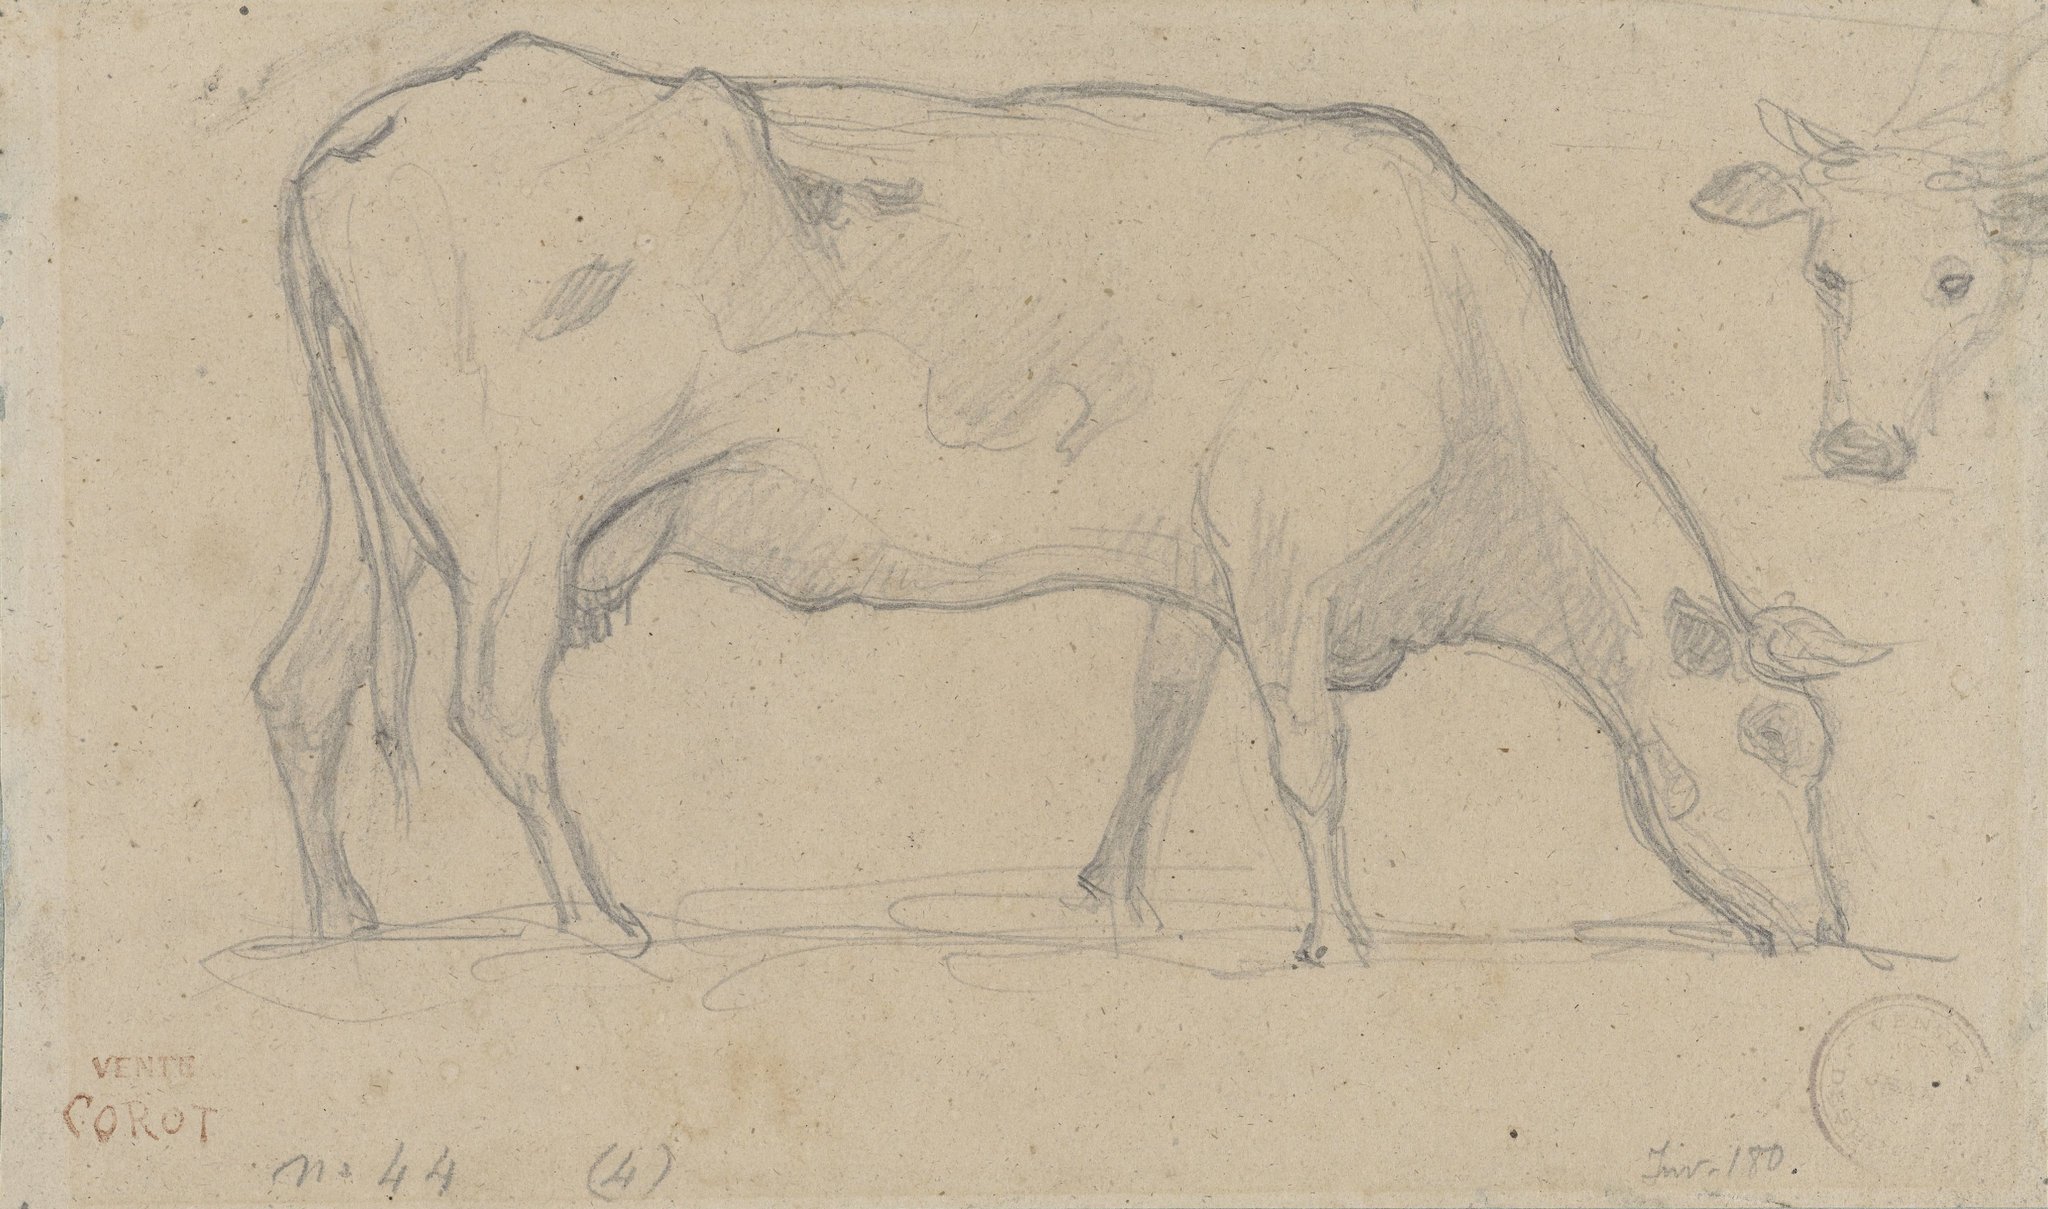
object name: drawing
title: Grazende koe, rechtsboven nogmaals een koeienkop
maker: camille corot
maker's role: draughtsman, painter, print maker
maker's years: 1796-1875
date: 1806-1875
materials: paper, pencil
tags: cow